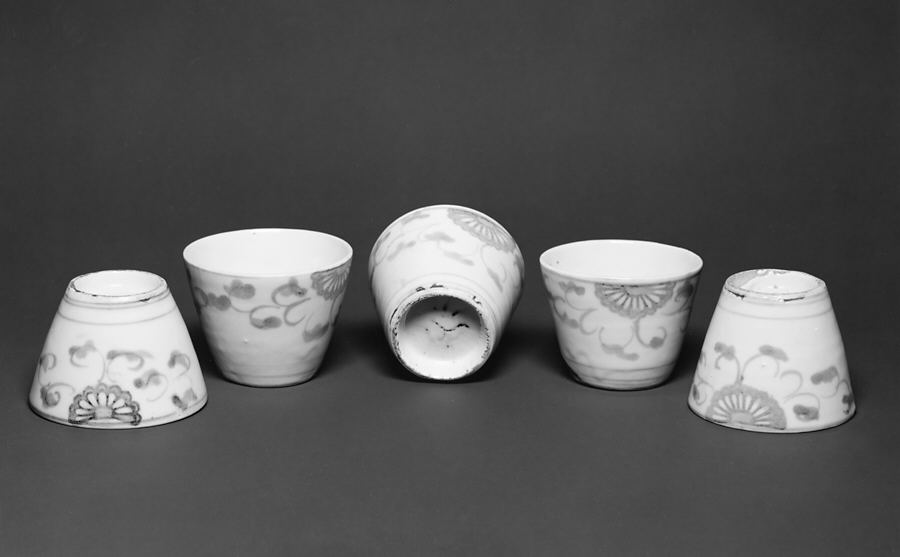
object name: soba cup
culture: japanese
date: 1801-1900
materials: cobalt, porcelain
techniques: painting, underglaze